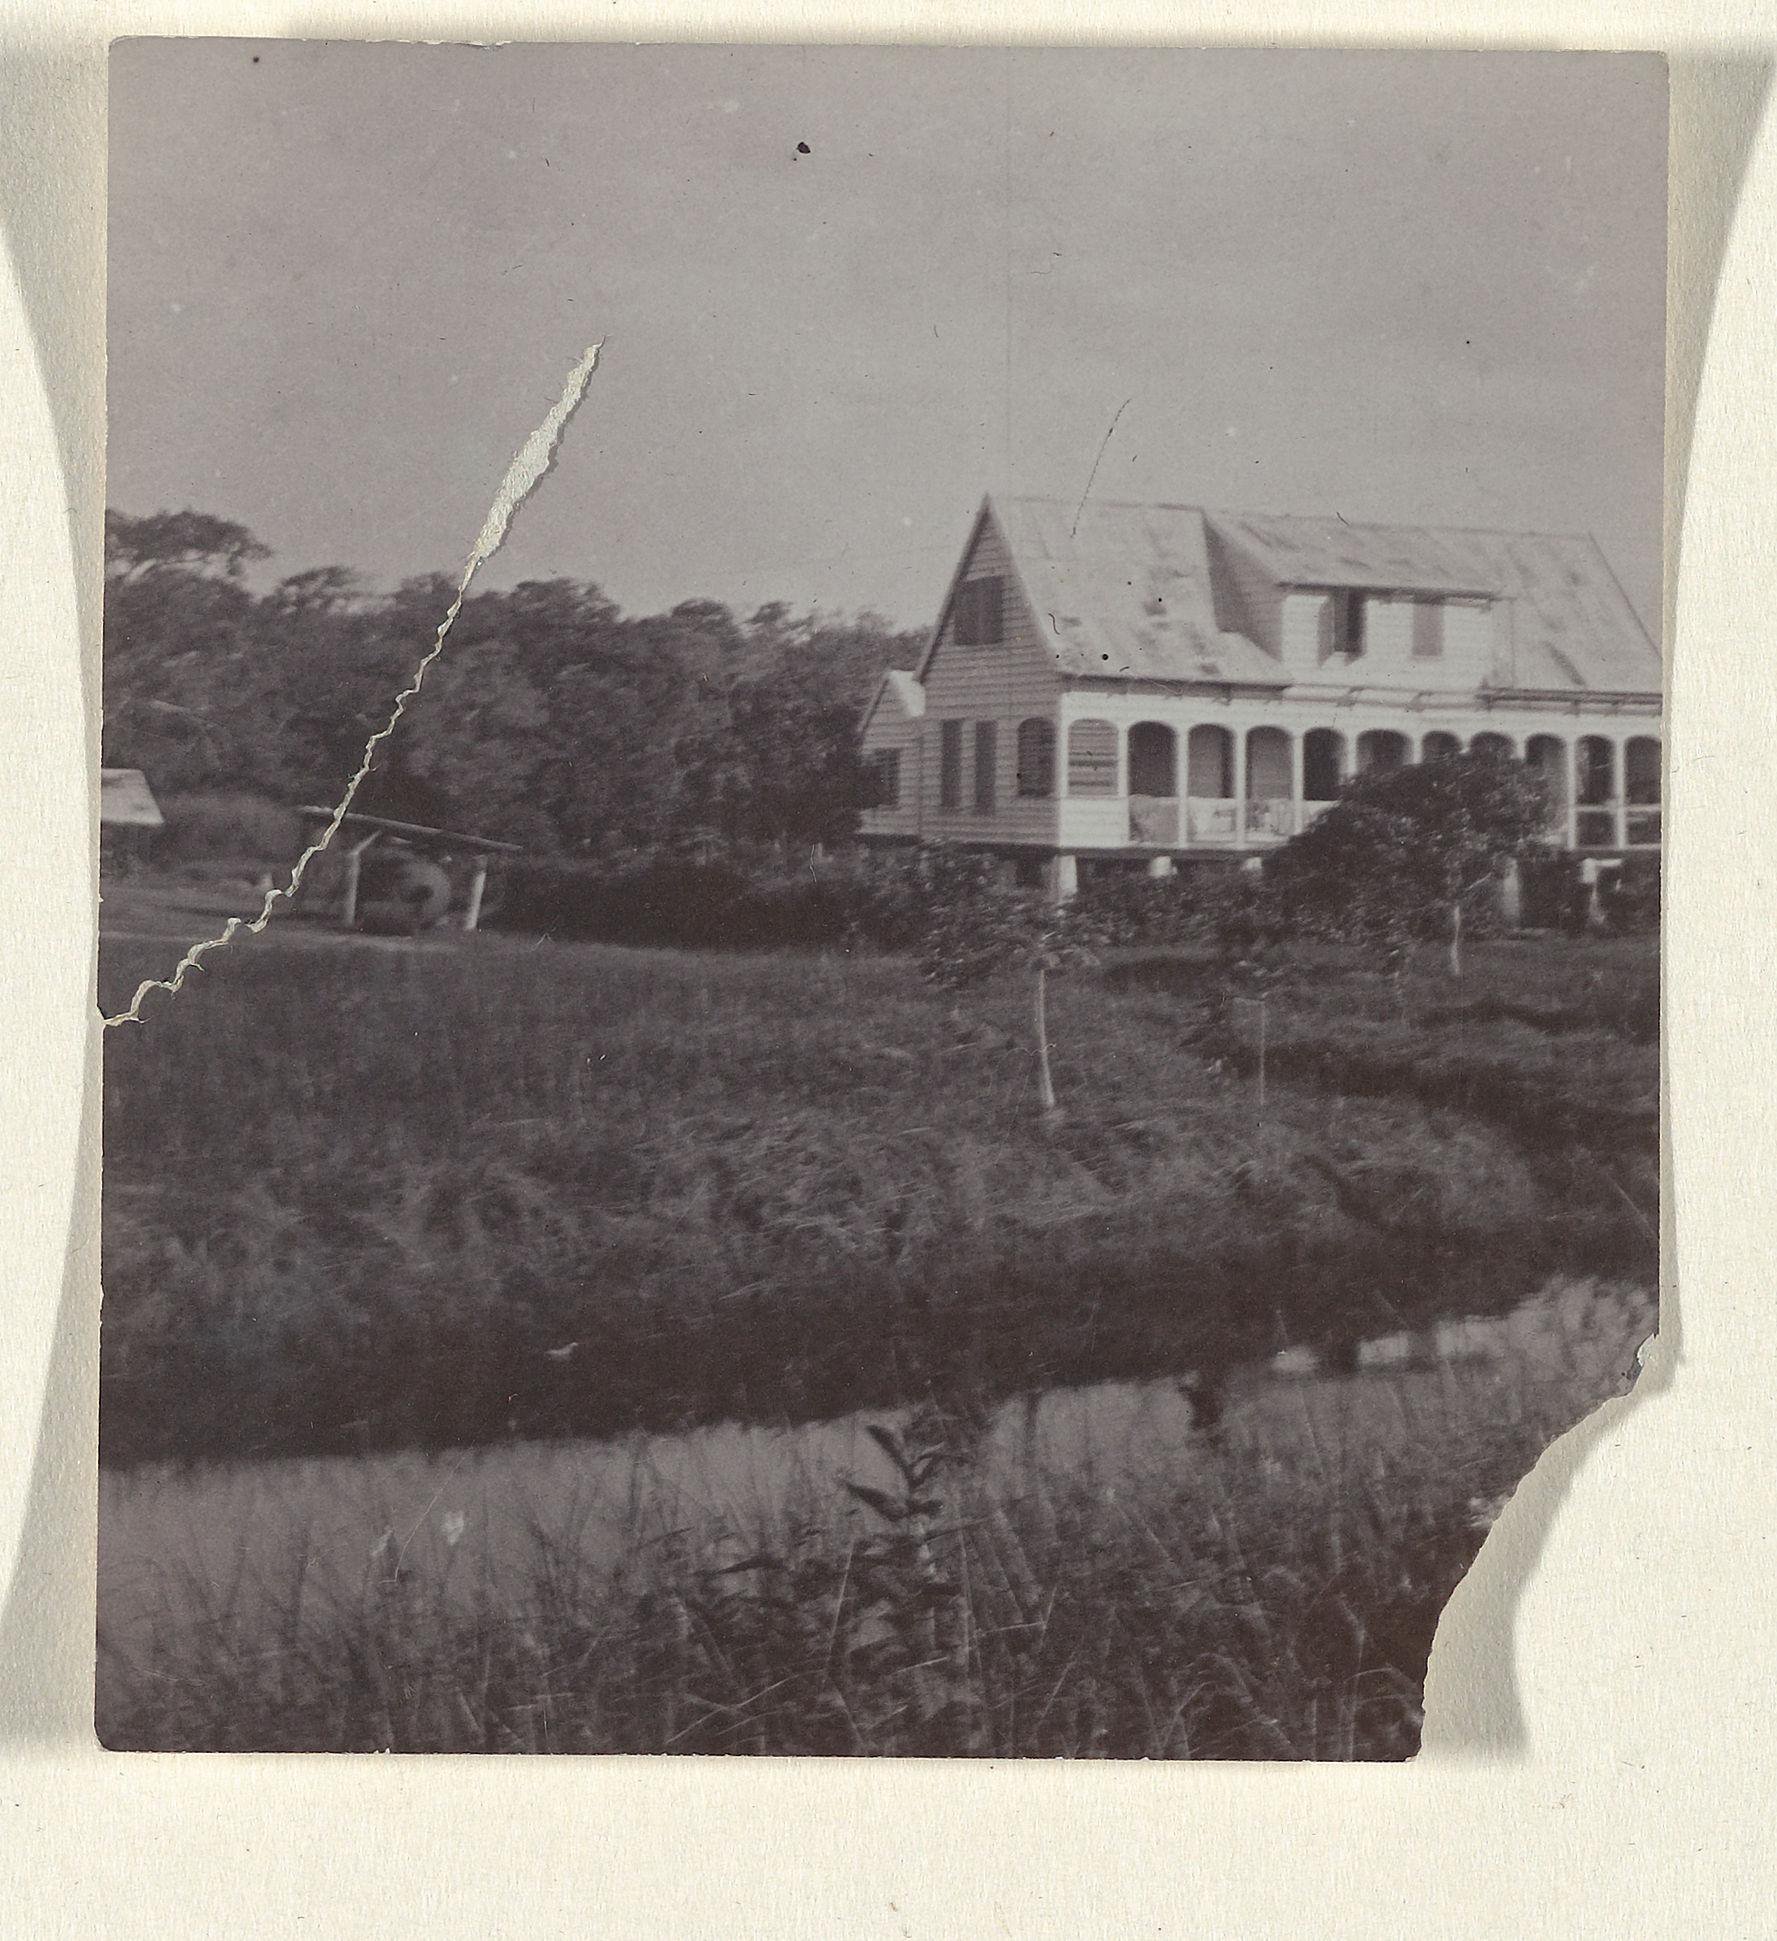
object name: photograph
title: Plantagewoning, vermoedelijk op plantage Clevia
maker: Anonymous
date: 1910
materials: photographic support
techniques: collodion silver print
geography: suriname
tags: plantation, suriname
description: Een plantagewoning, vermoedelijk op plantage Clevia. Losse foto in het fotoalbum over de familie Gonggrijp op de plantages Clevia en Morgenstond in Suriname rond 1910.